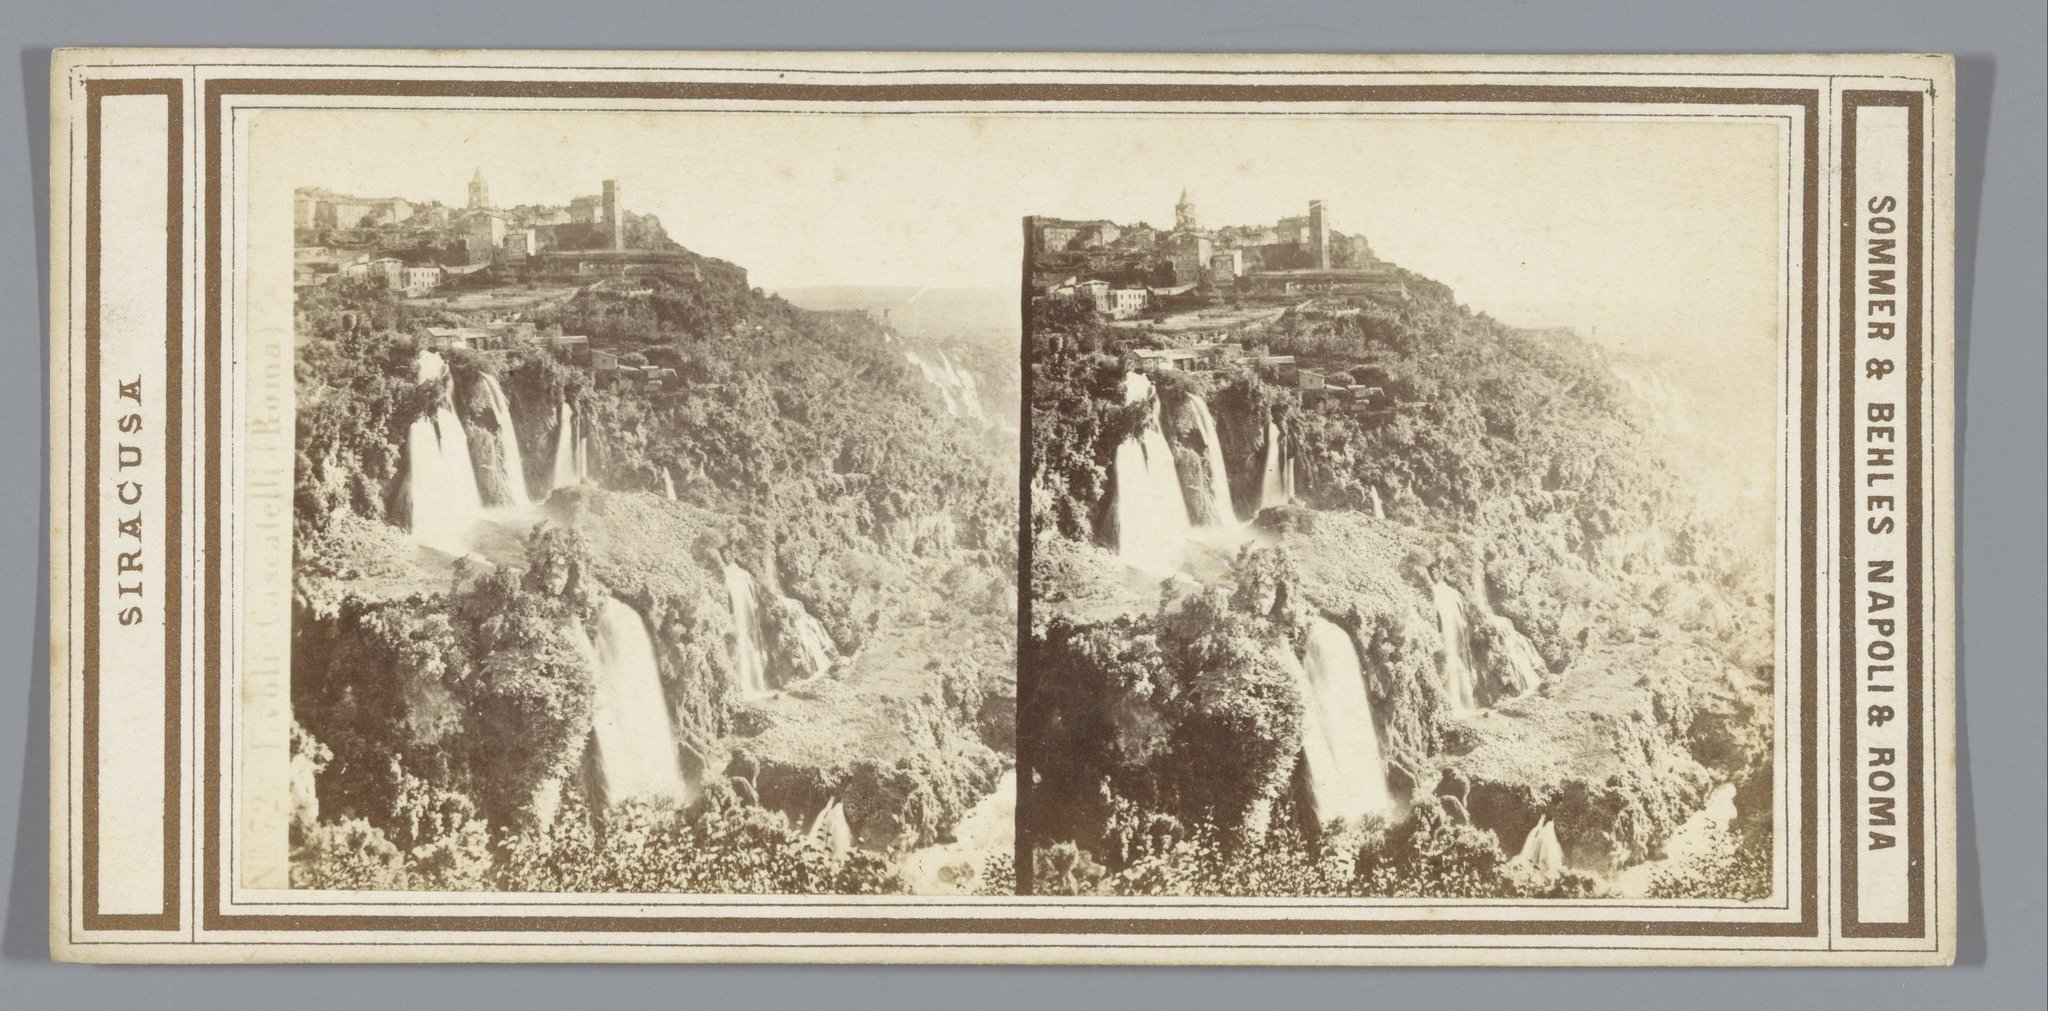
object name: stereograph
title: Gezicht op de watervallen bij Tivoli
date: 1860-1880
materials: cardboard, photographic support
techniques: albumen print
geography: lazio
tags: waterfall, tivoli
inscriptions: number: ‘No. 72.’